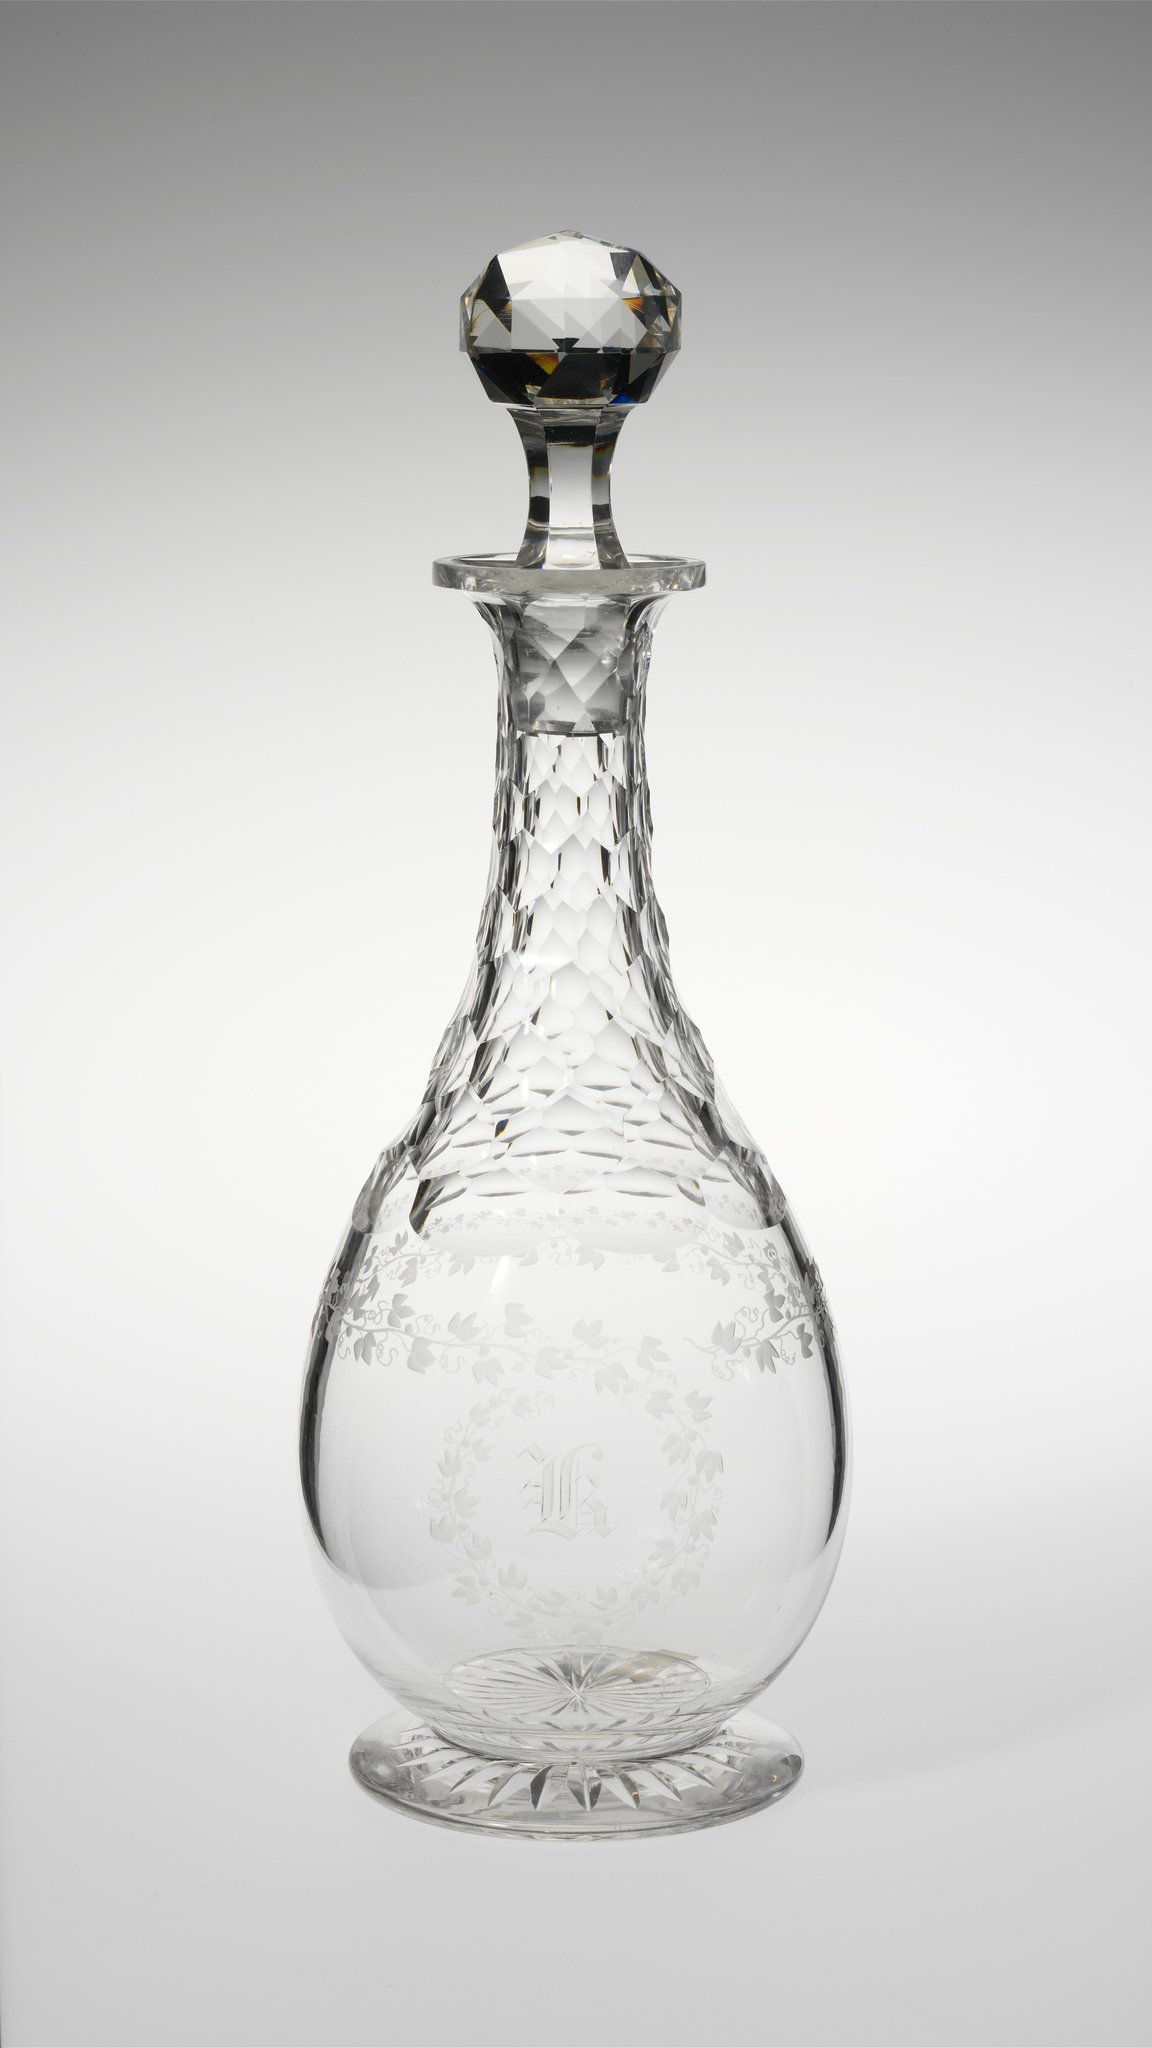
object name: decanter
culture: american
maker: boston & sandwich glass company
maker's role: maker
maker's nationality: american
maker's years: 1825-1888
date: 1867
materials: glass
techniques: glassblowing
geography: united states